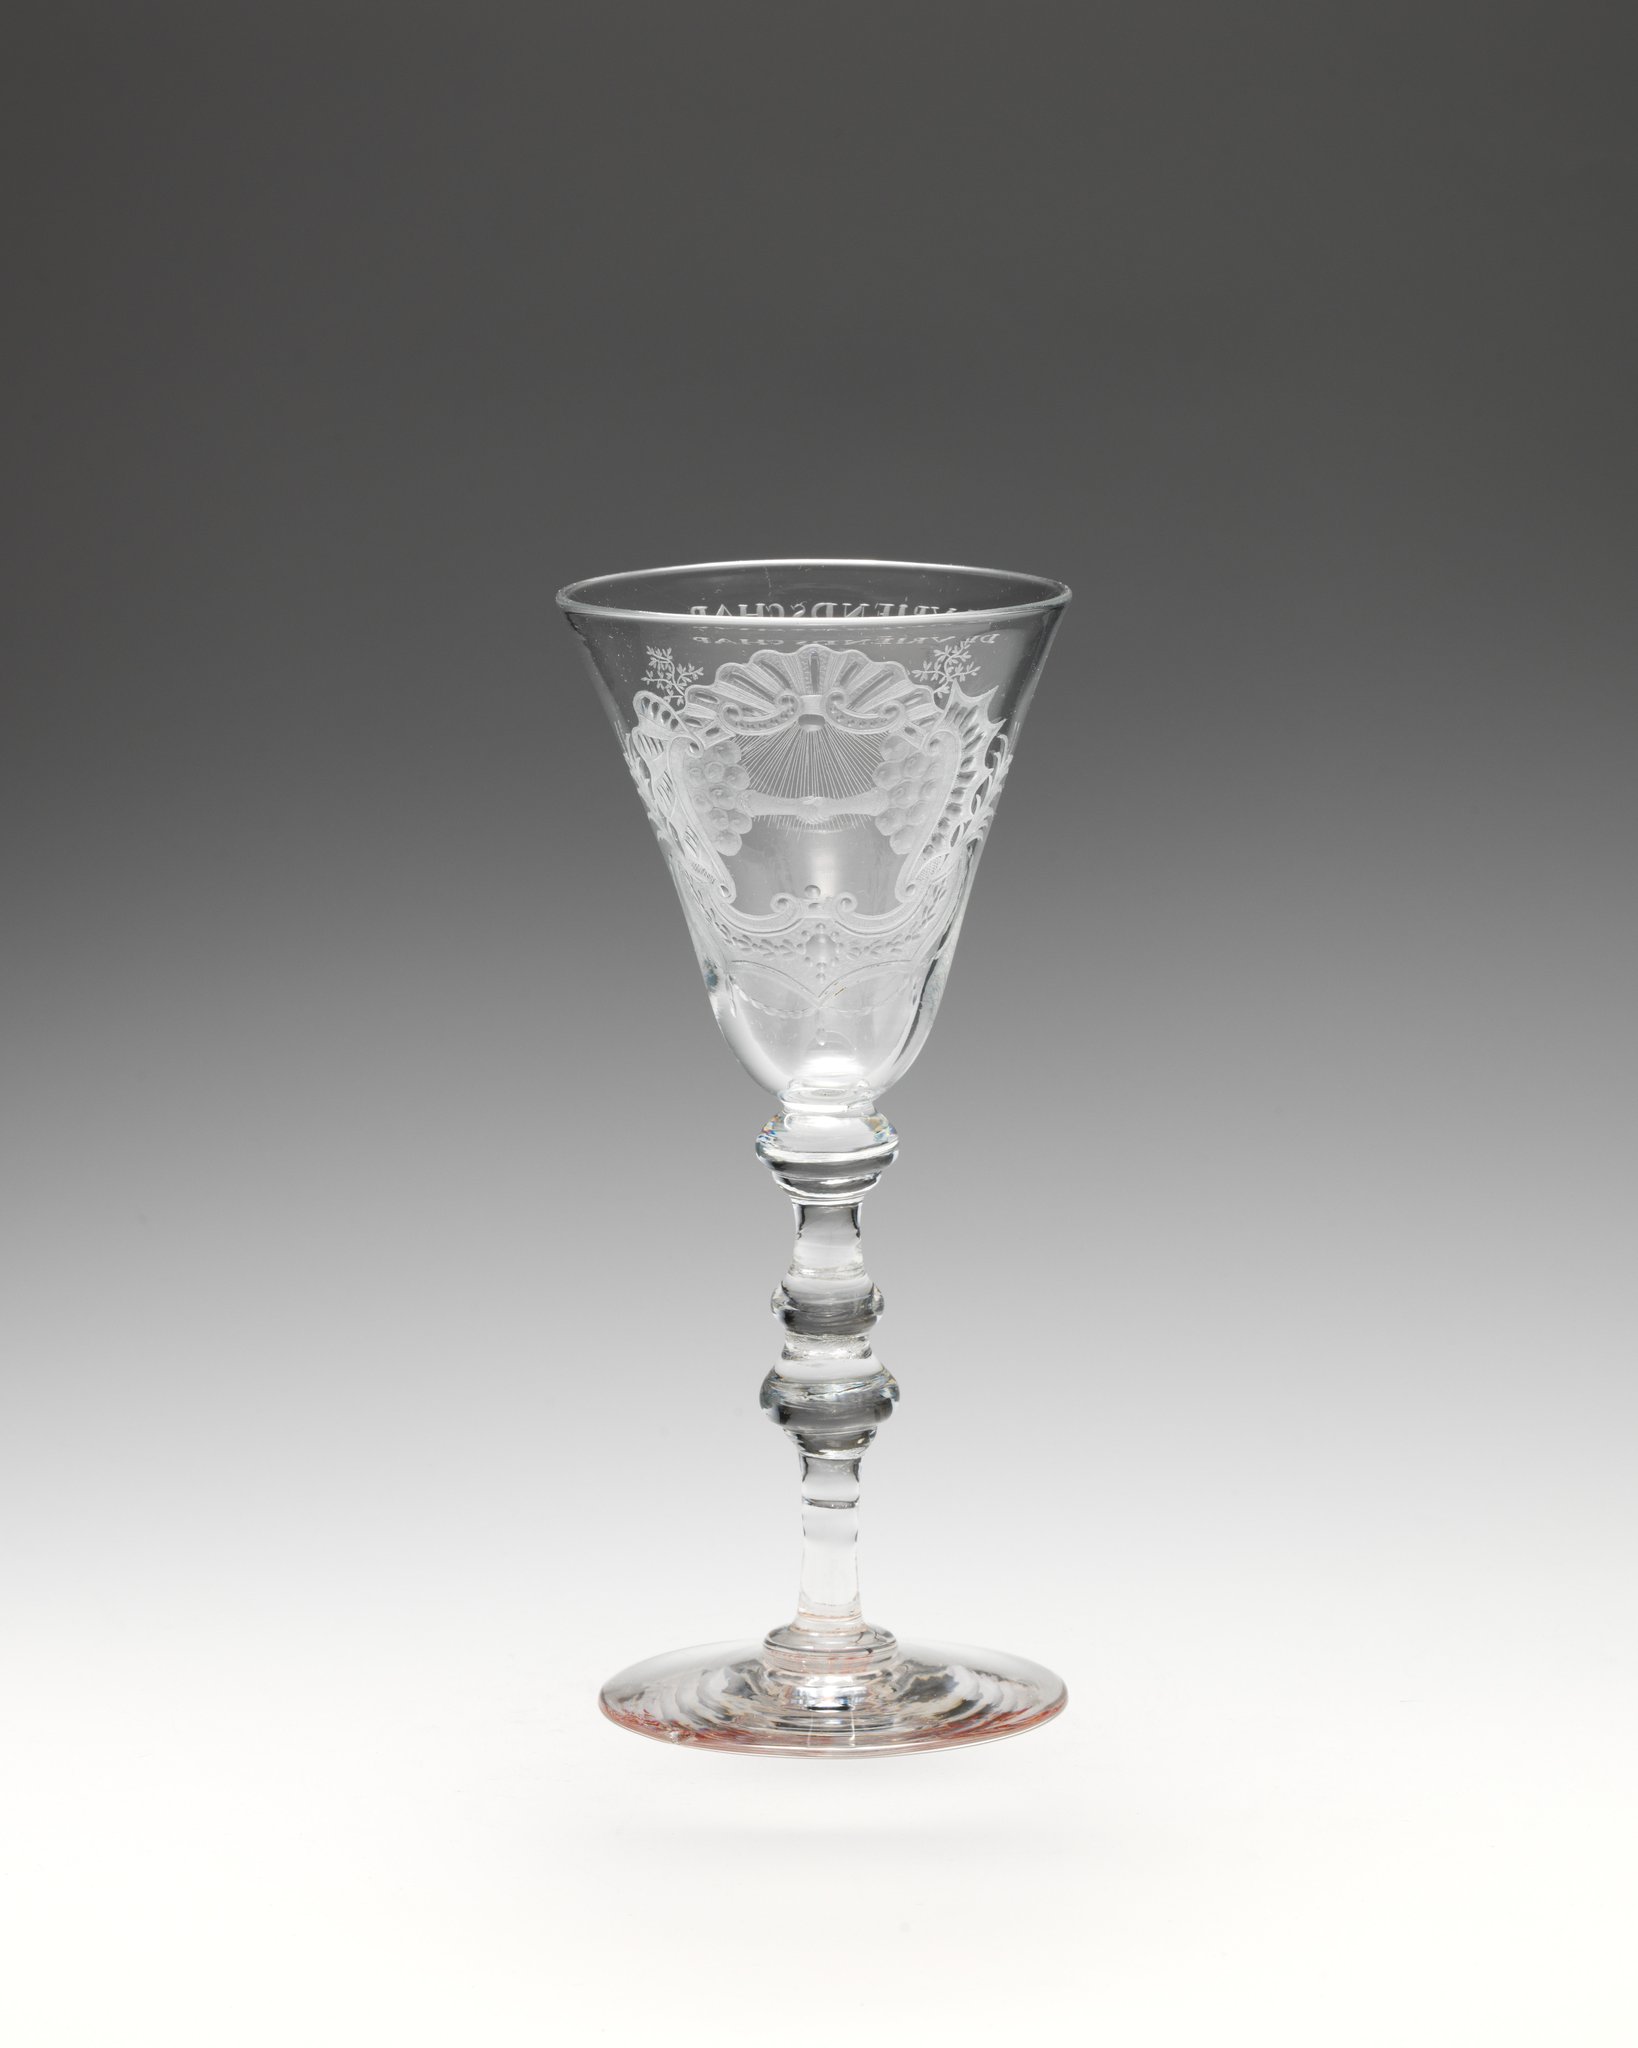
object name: wineglass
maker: simon jacob sang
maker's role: engraver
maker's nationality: dutch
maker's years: 1720-1786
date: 1752-1762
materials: glass